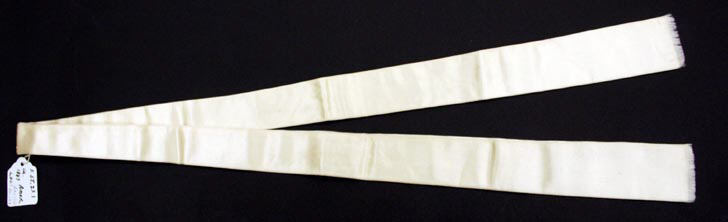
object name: wedding necktie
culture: american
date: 1887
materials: silk